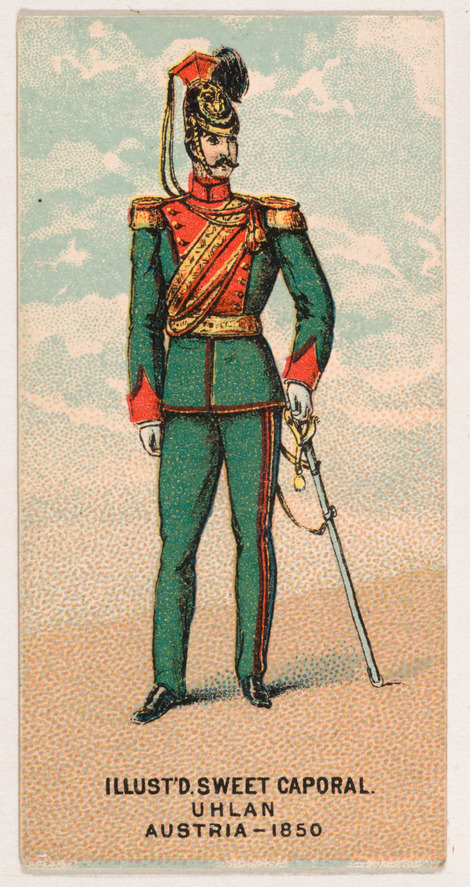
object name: print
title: Uhlan, Austria, 1850, from the Military Series (N224) issued by Kinney Tobacco Company to promote Sweet Caporal Cigarettes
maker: kinney brothers tobacco company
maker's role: publisher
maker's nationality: american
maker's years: 1869-2011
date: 1888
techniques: color lithograph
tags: military,weapons,men